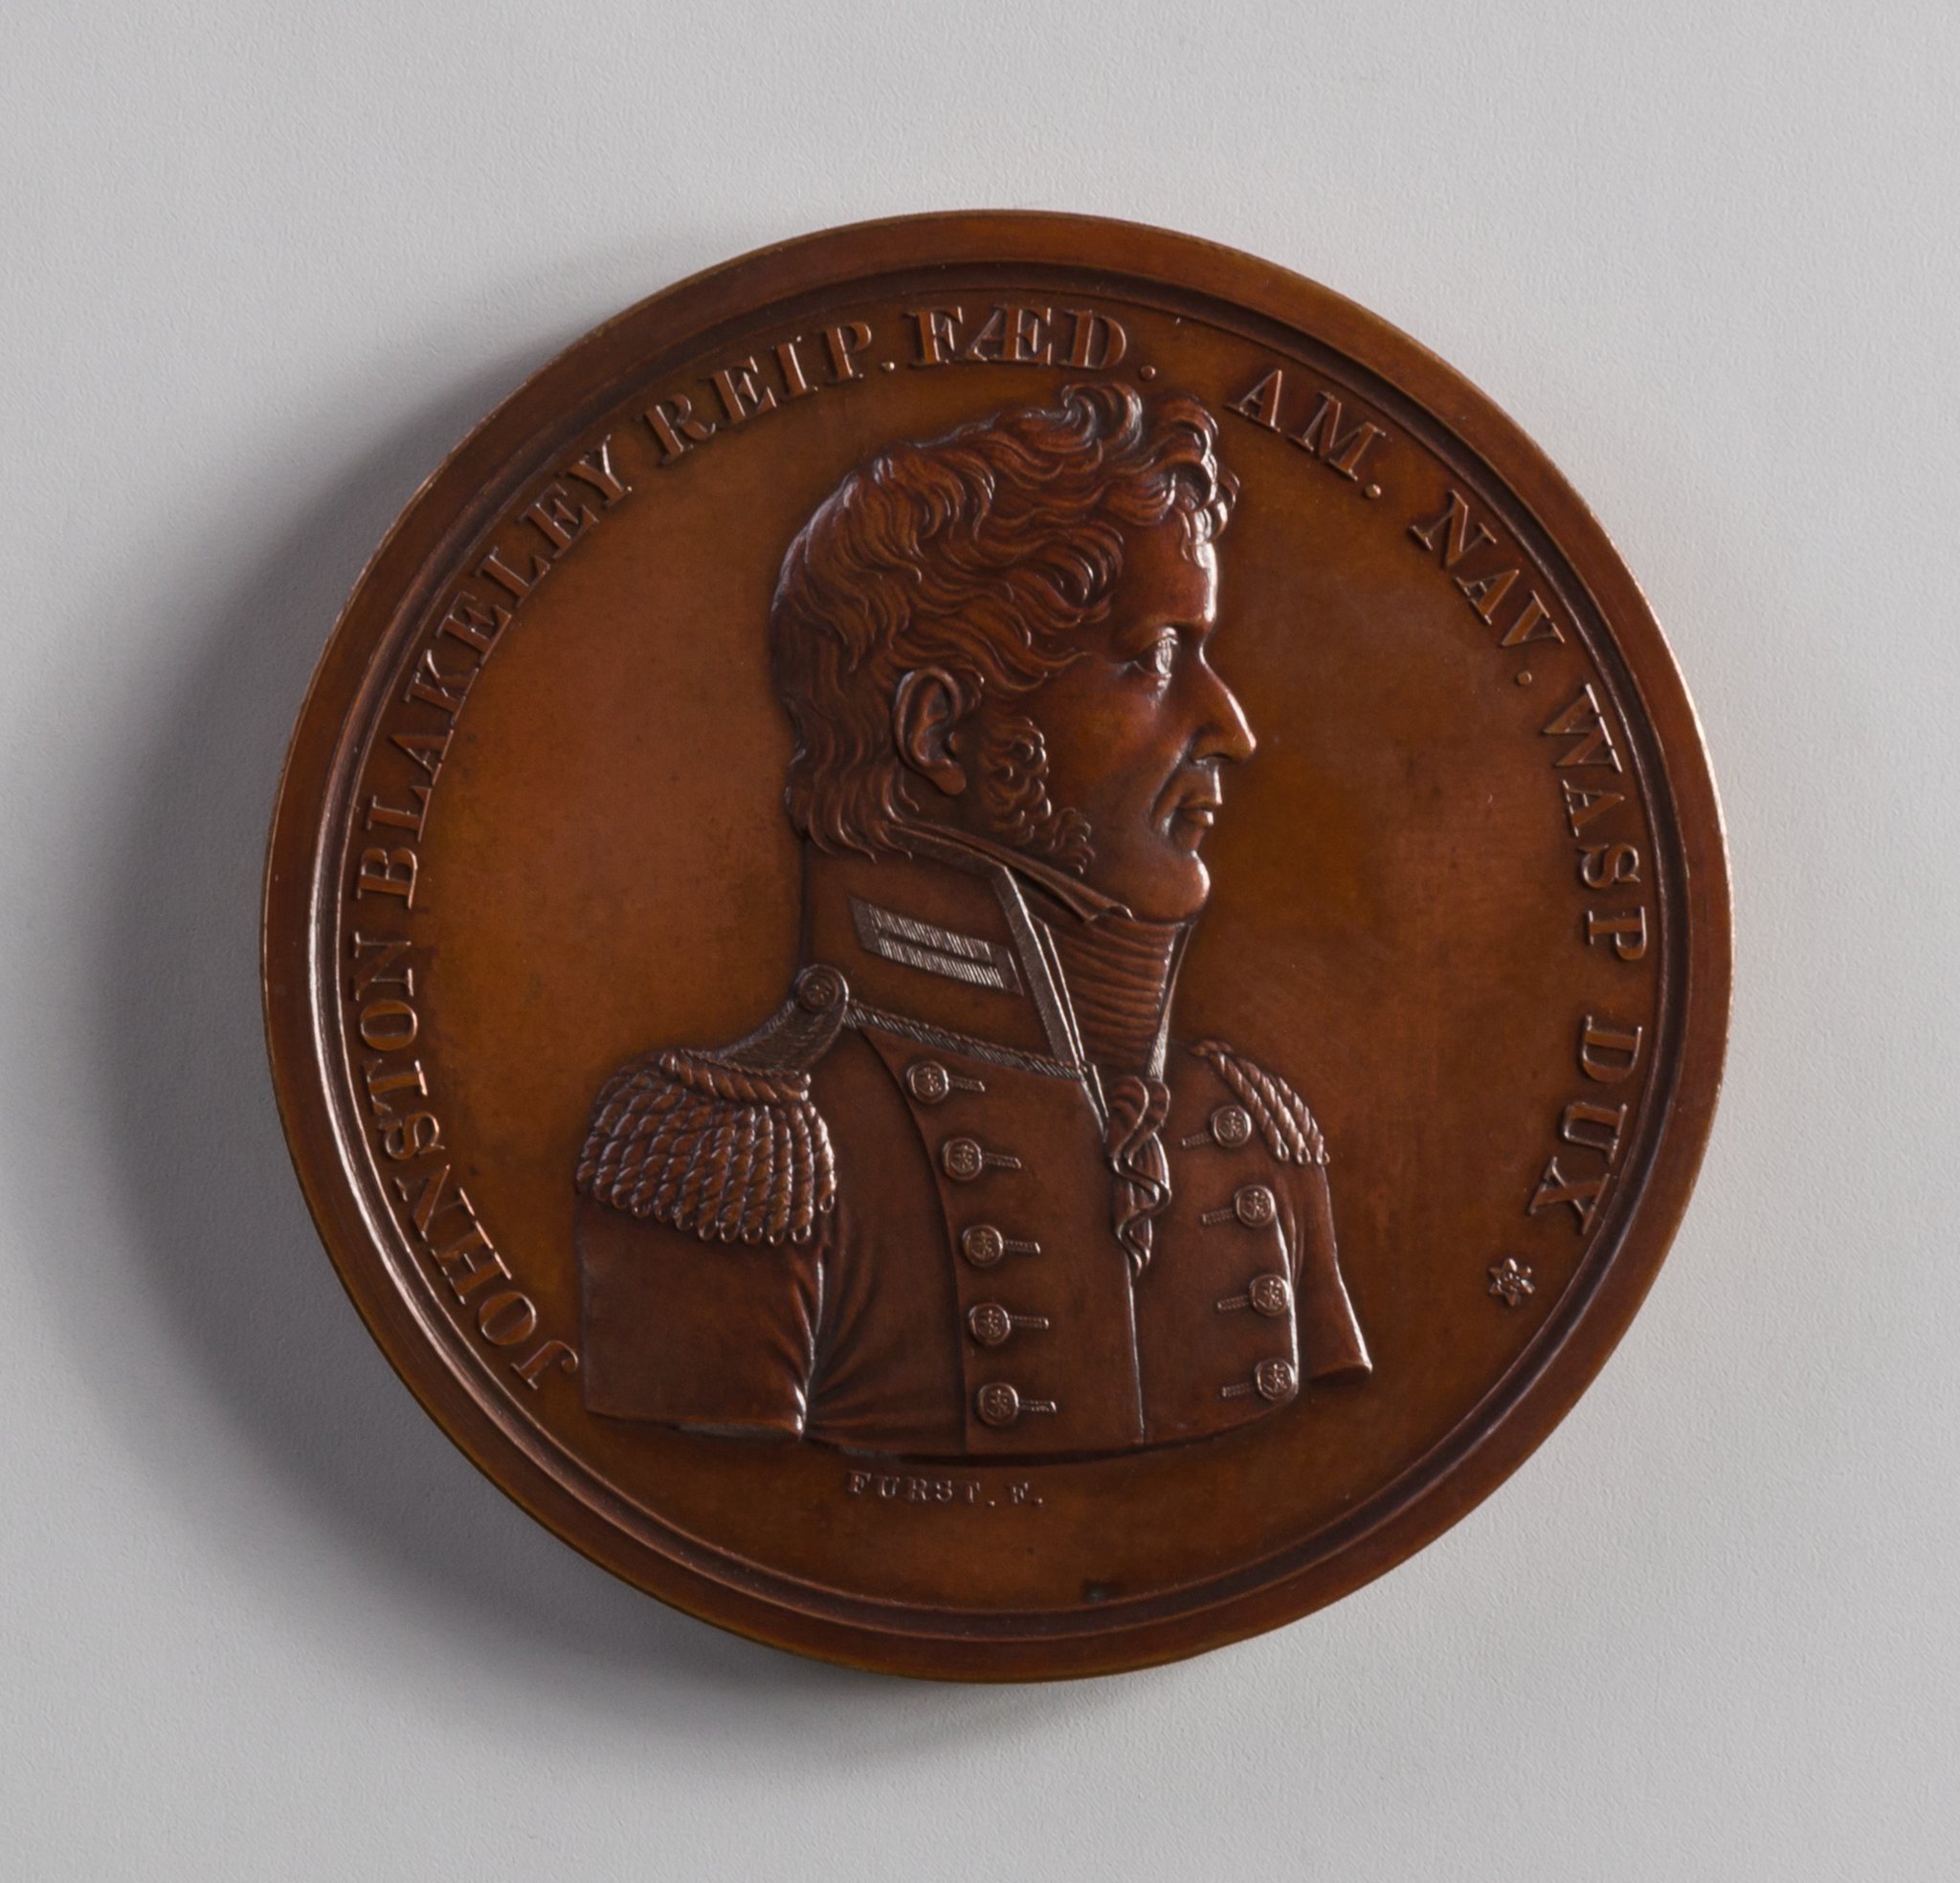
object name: medal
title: Medal of Captain Johnston Blakely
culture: american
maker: moritz fürst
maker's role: maker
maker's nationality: hungarian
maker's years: 1782-1882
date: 1800-1830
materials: bronze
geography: united states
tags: profiles